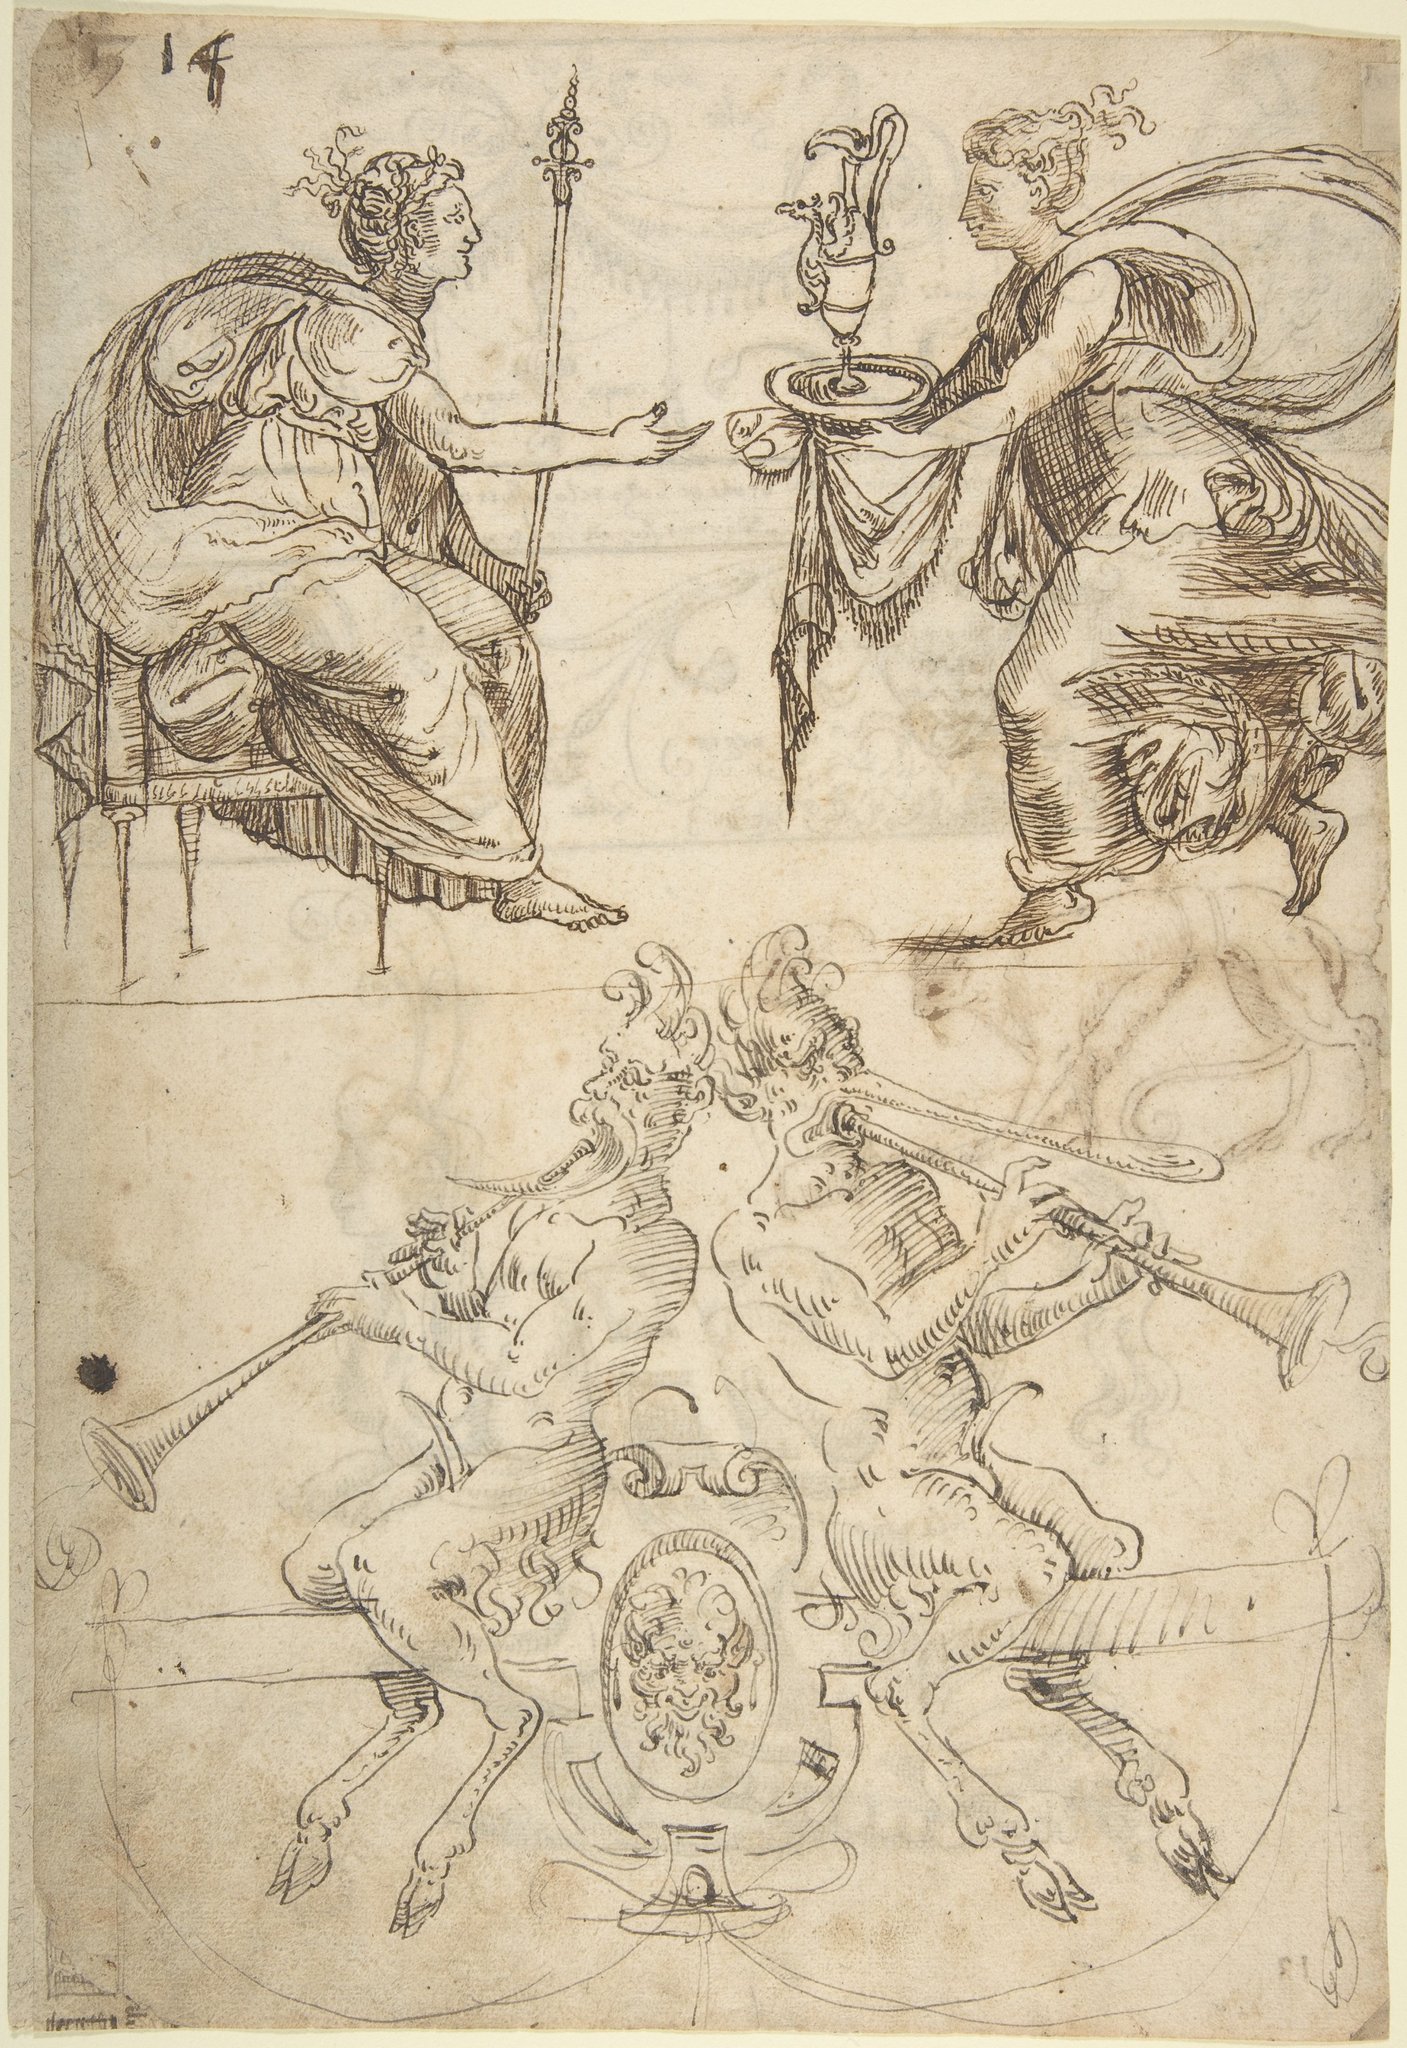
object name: drawing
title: Sheet with multiple Designs: Figurative Scene with Two Women (top) and Two Satyrs Playing Horns, Seated Back to Back (bottom) (recto); Three Candelabra Grotesques (verso)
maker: andrés de melgar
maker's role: artist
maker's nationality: spanish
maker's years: 1554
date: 1545-1560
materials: ink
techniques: pen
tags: women,horns,satyrs